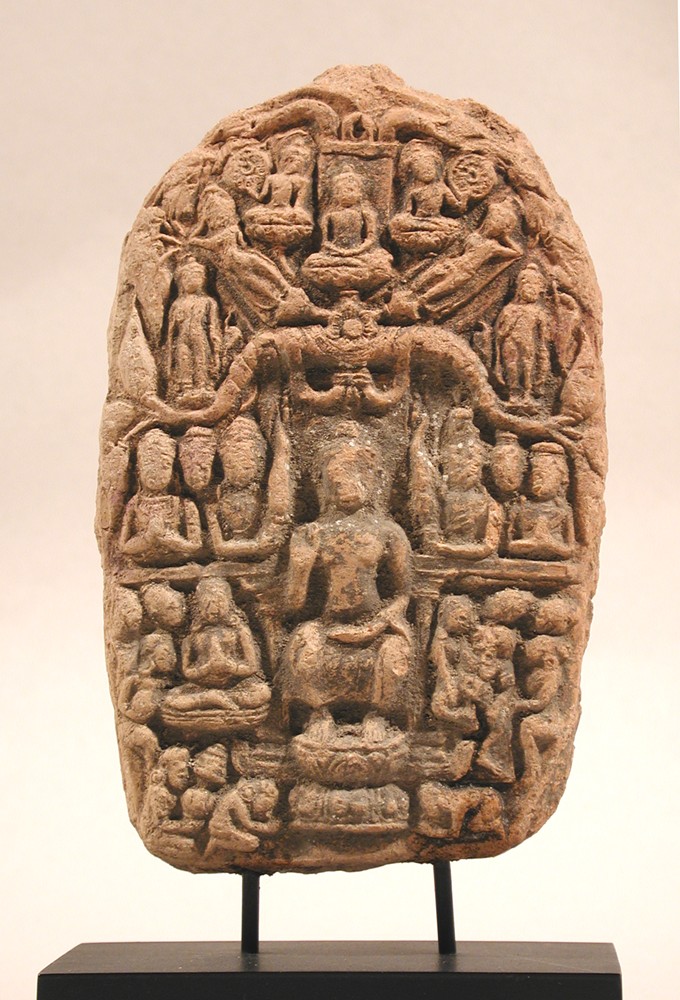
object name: plaque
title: The Miracle of Shravasti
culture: thai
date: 601-900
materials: terracotta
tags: human figures